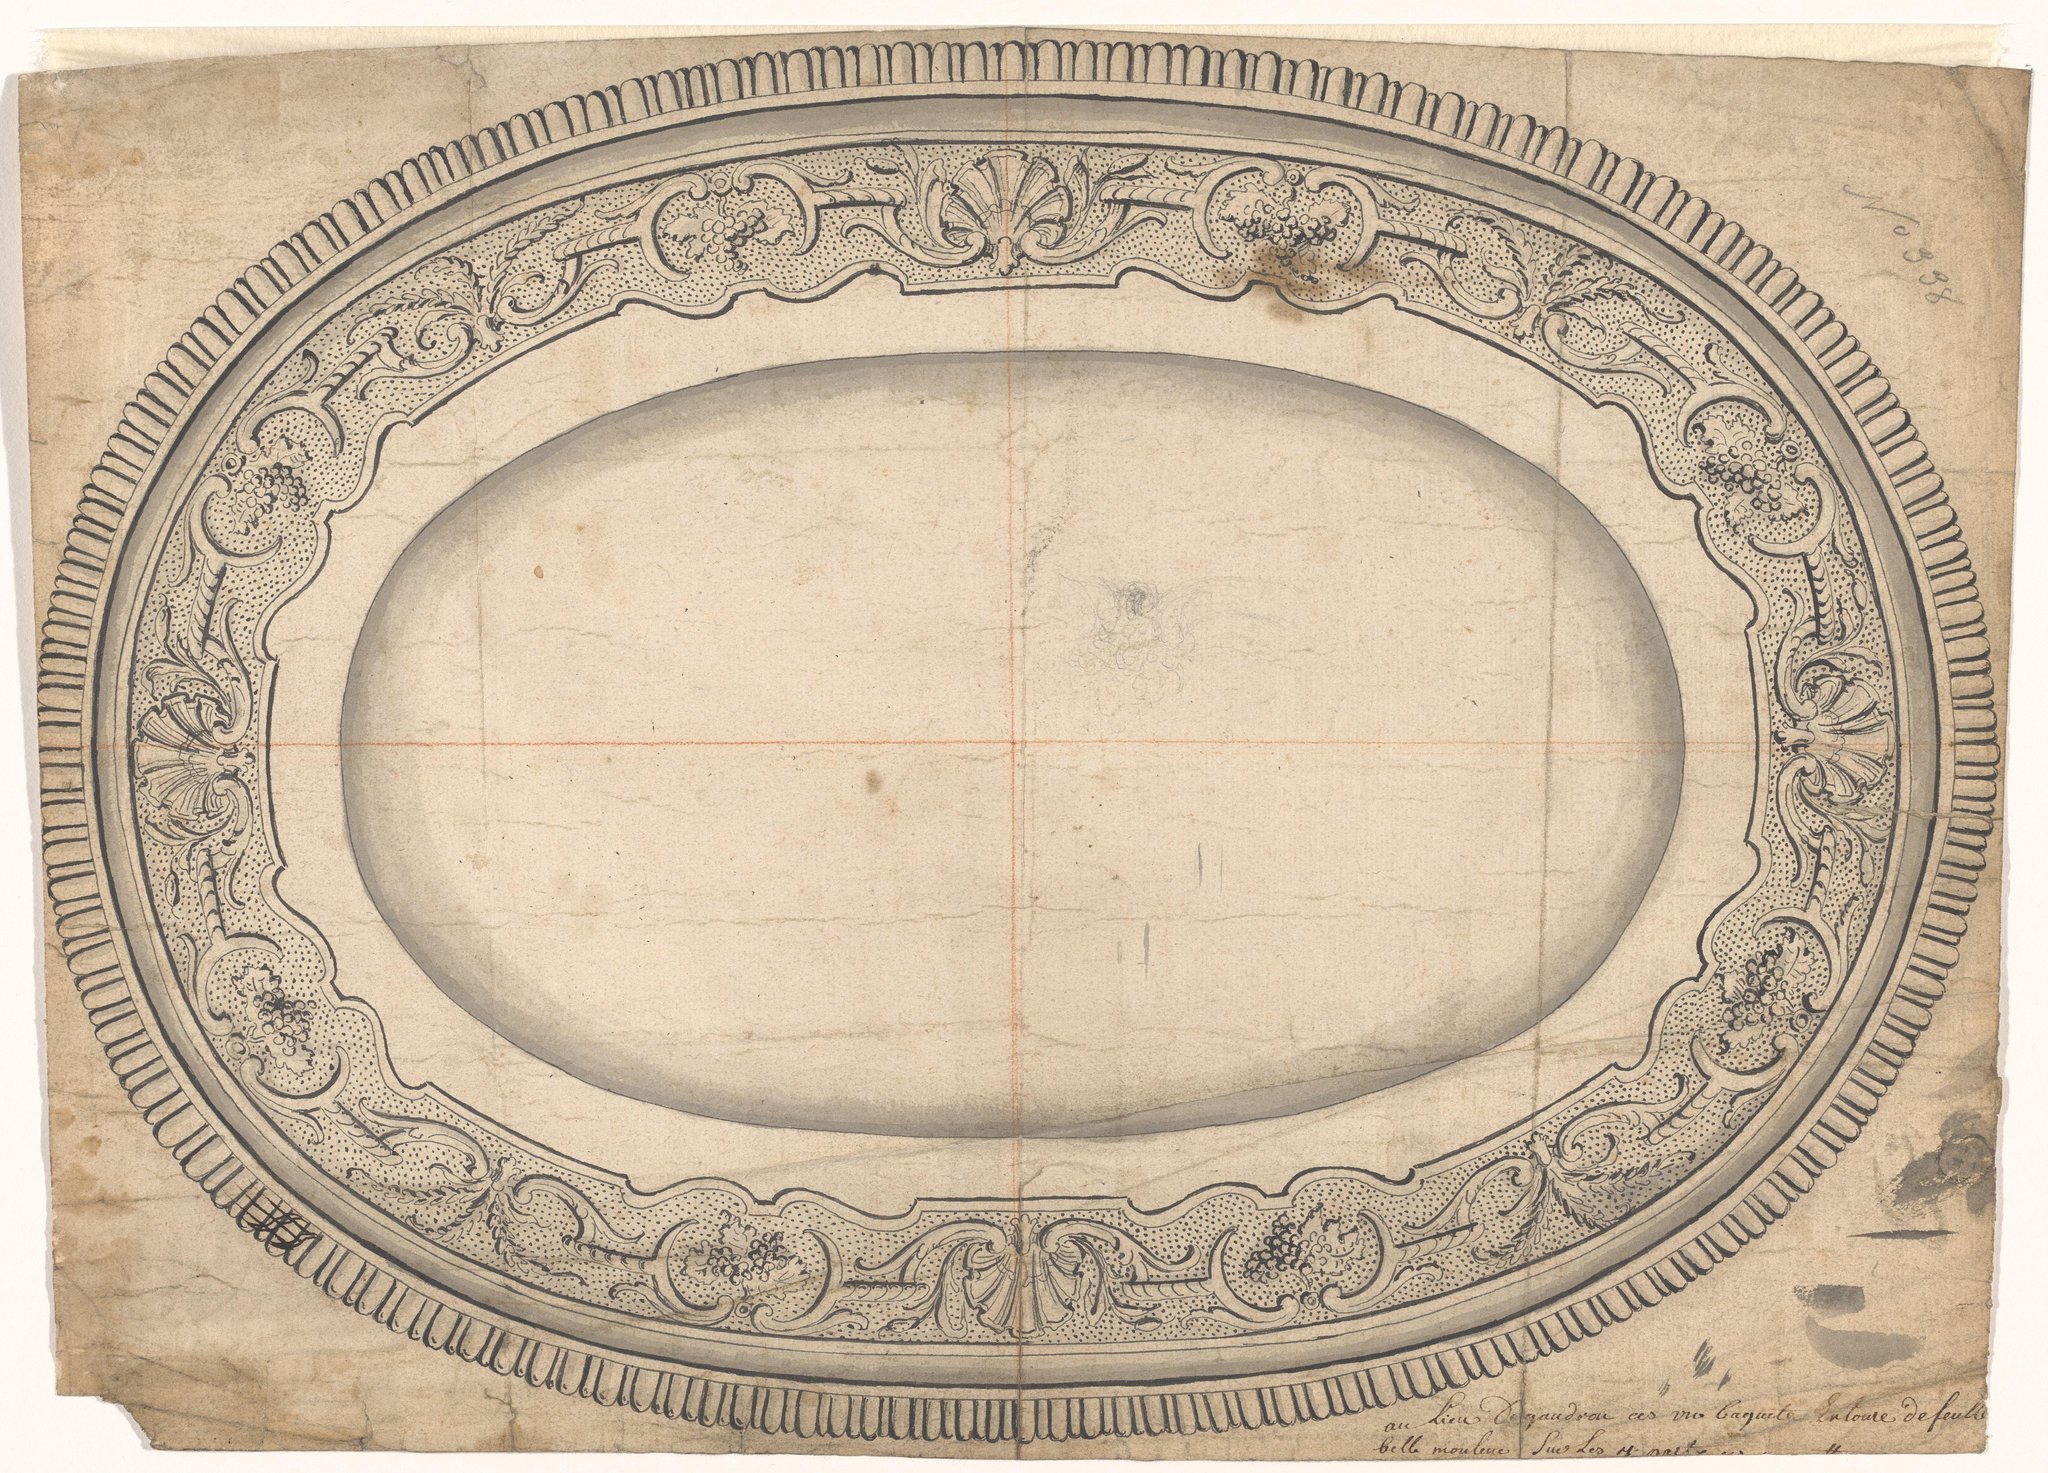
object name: design drawing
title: Ontwerp voor een schaal met druiventrossen in de rand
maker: Anonymous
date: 1700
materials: chalk, ink, paper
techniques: pen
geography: paris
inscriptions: number: ‘No 338’, watermark, inscription: ‘au Lieu de gaudron ces une baguette Entoure de feulle[…] / belle moulure Sur Les 4 [ ?] part[…].’